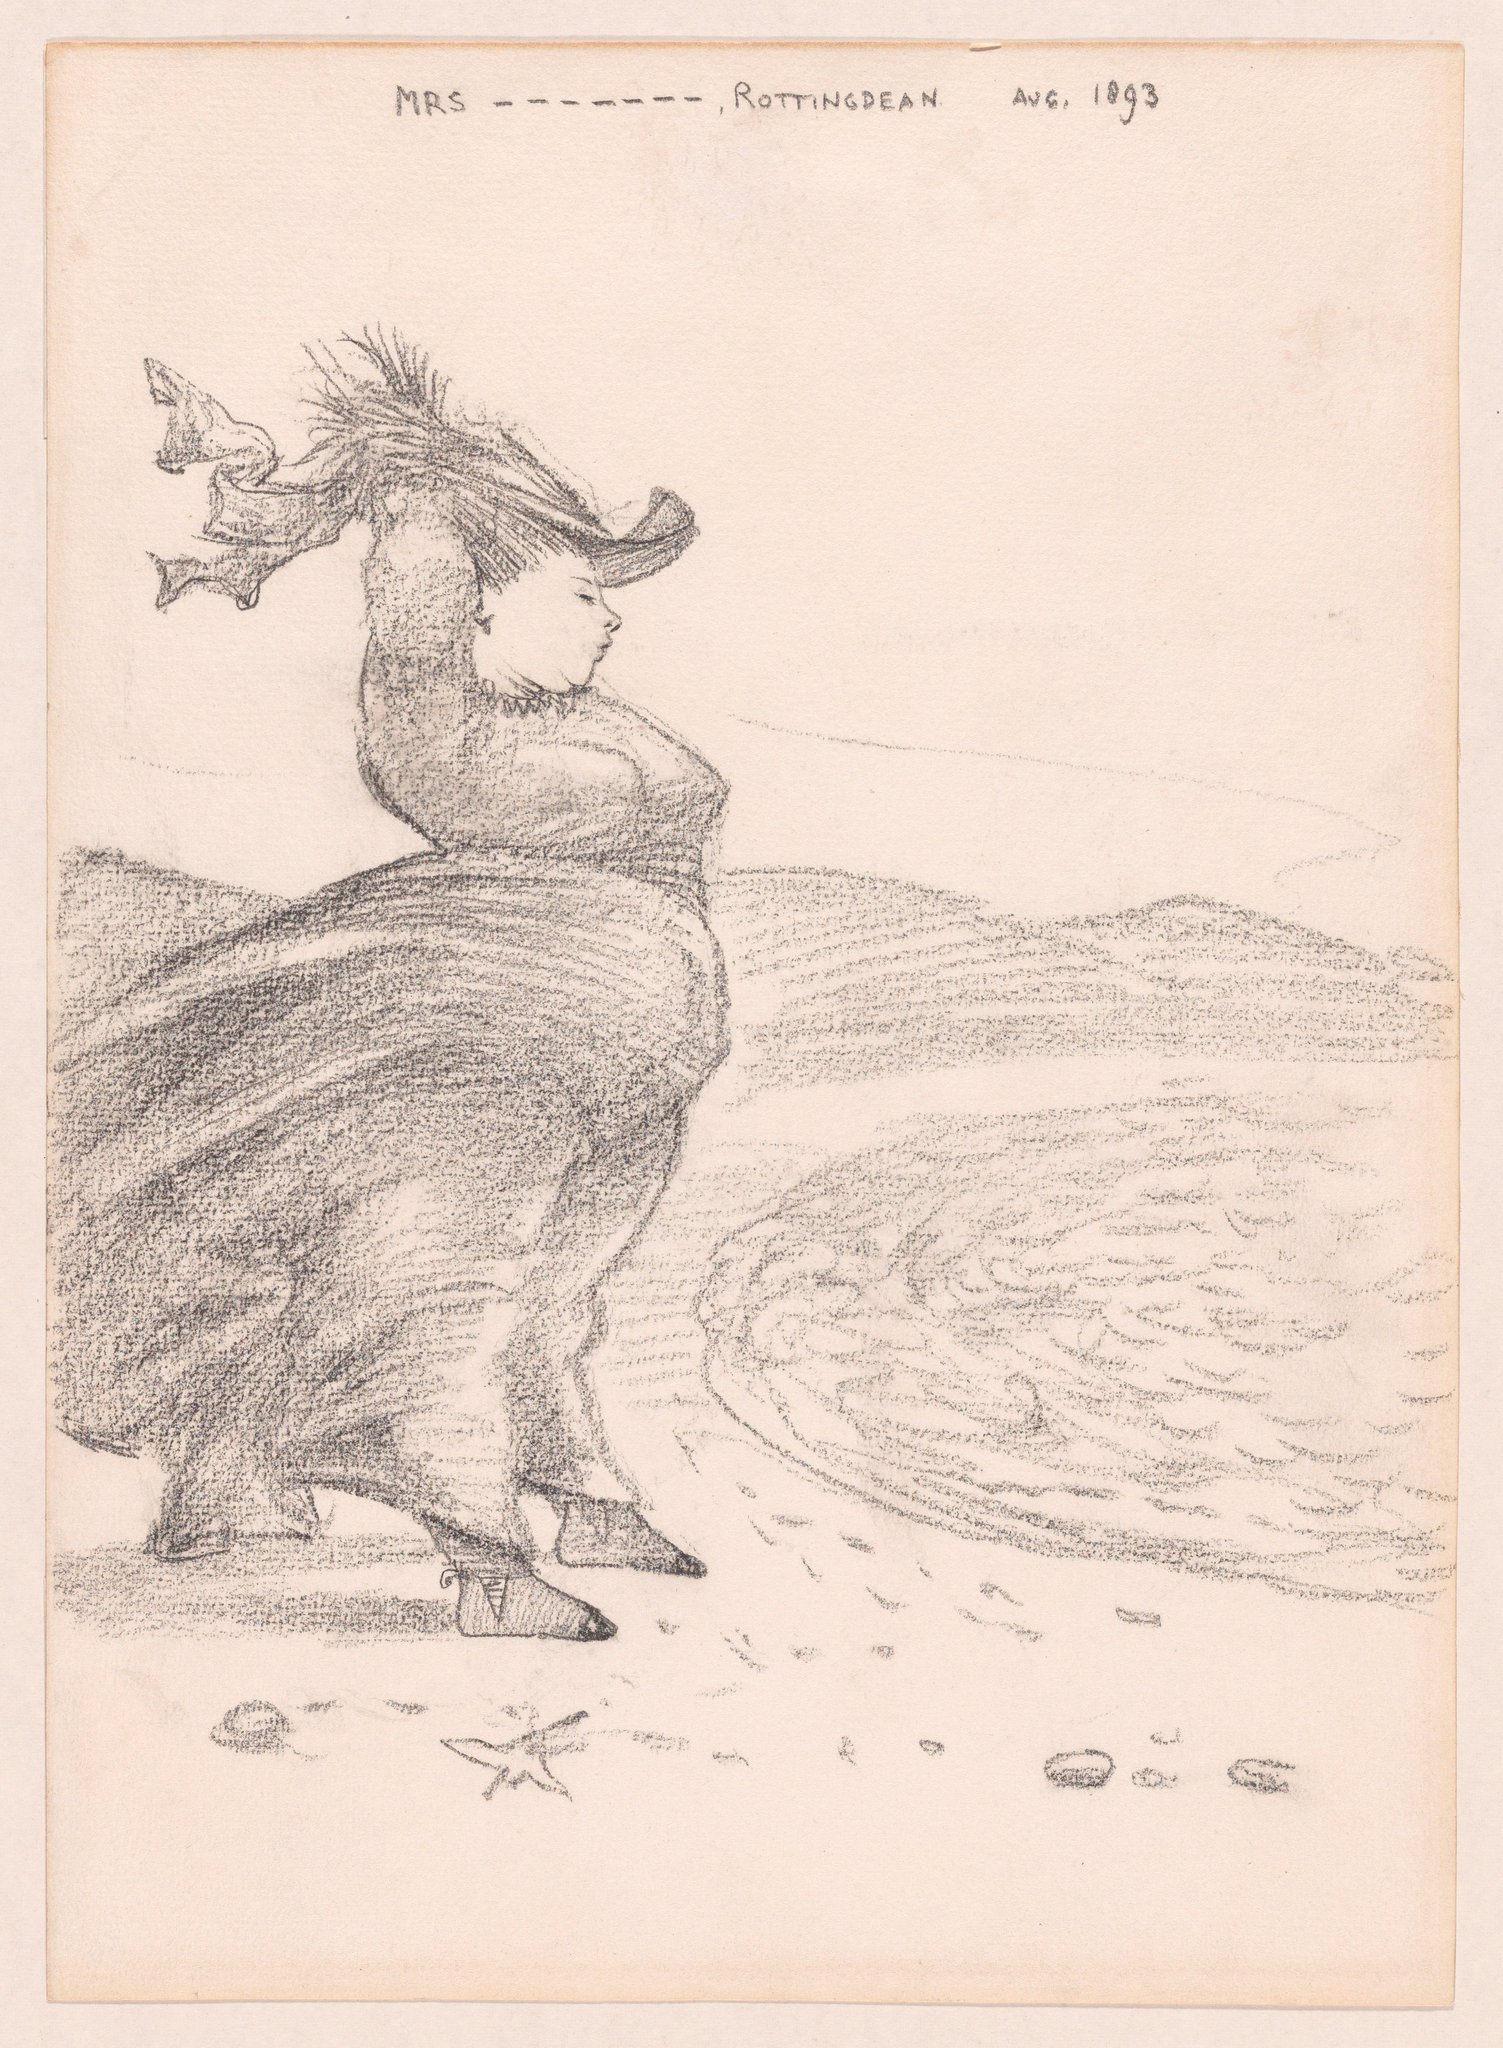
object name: drawing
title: Caricature of a windblown woman on the beach at Rottingdean, Sussex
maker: sir edward burne-jones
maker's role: artist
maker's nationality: british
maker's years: 1833-1898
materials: chalk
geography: great britain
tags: women,beaches,wind,caricature